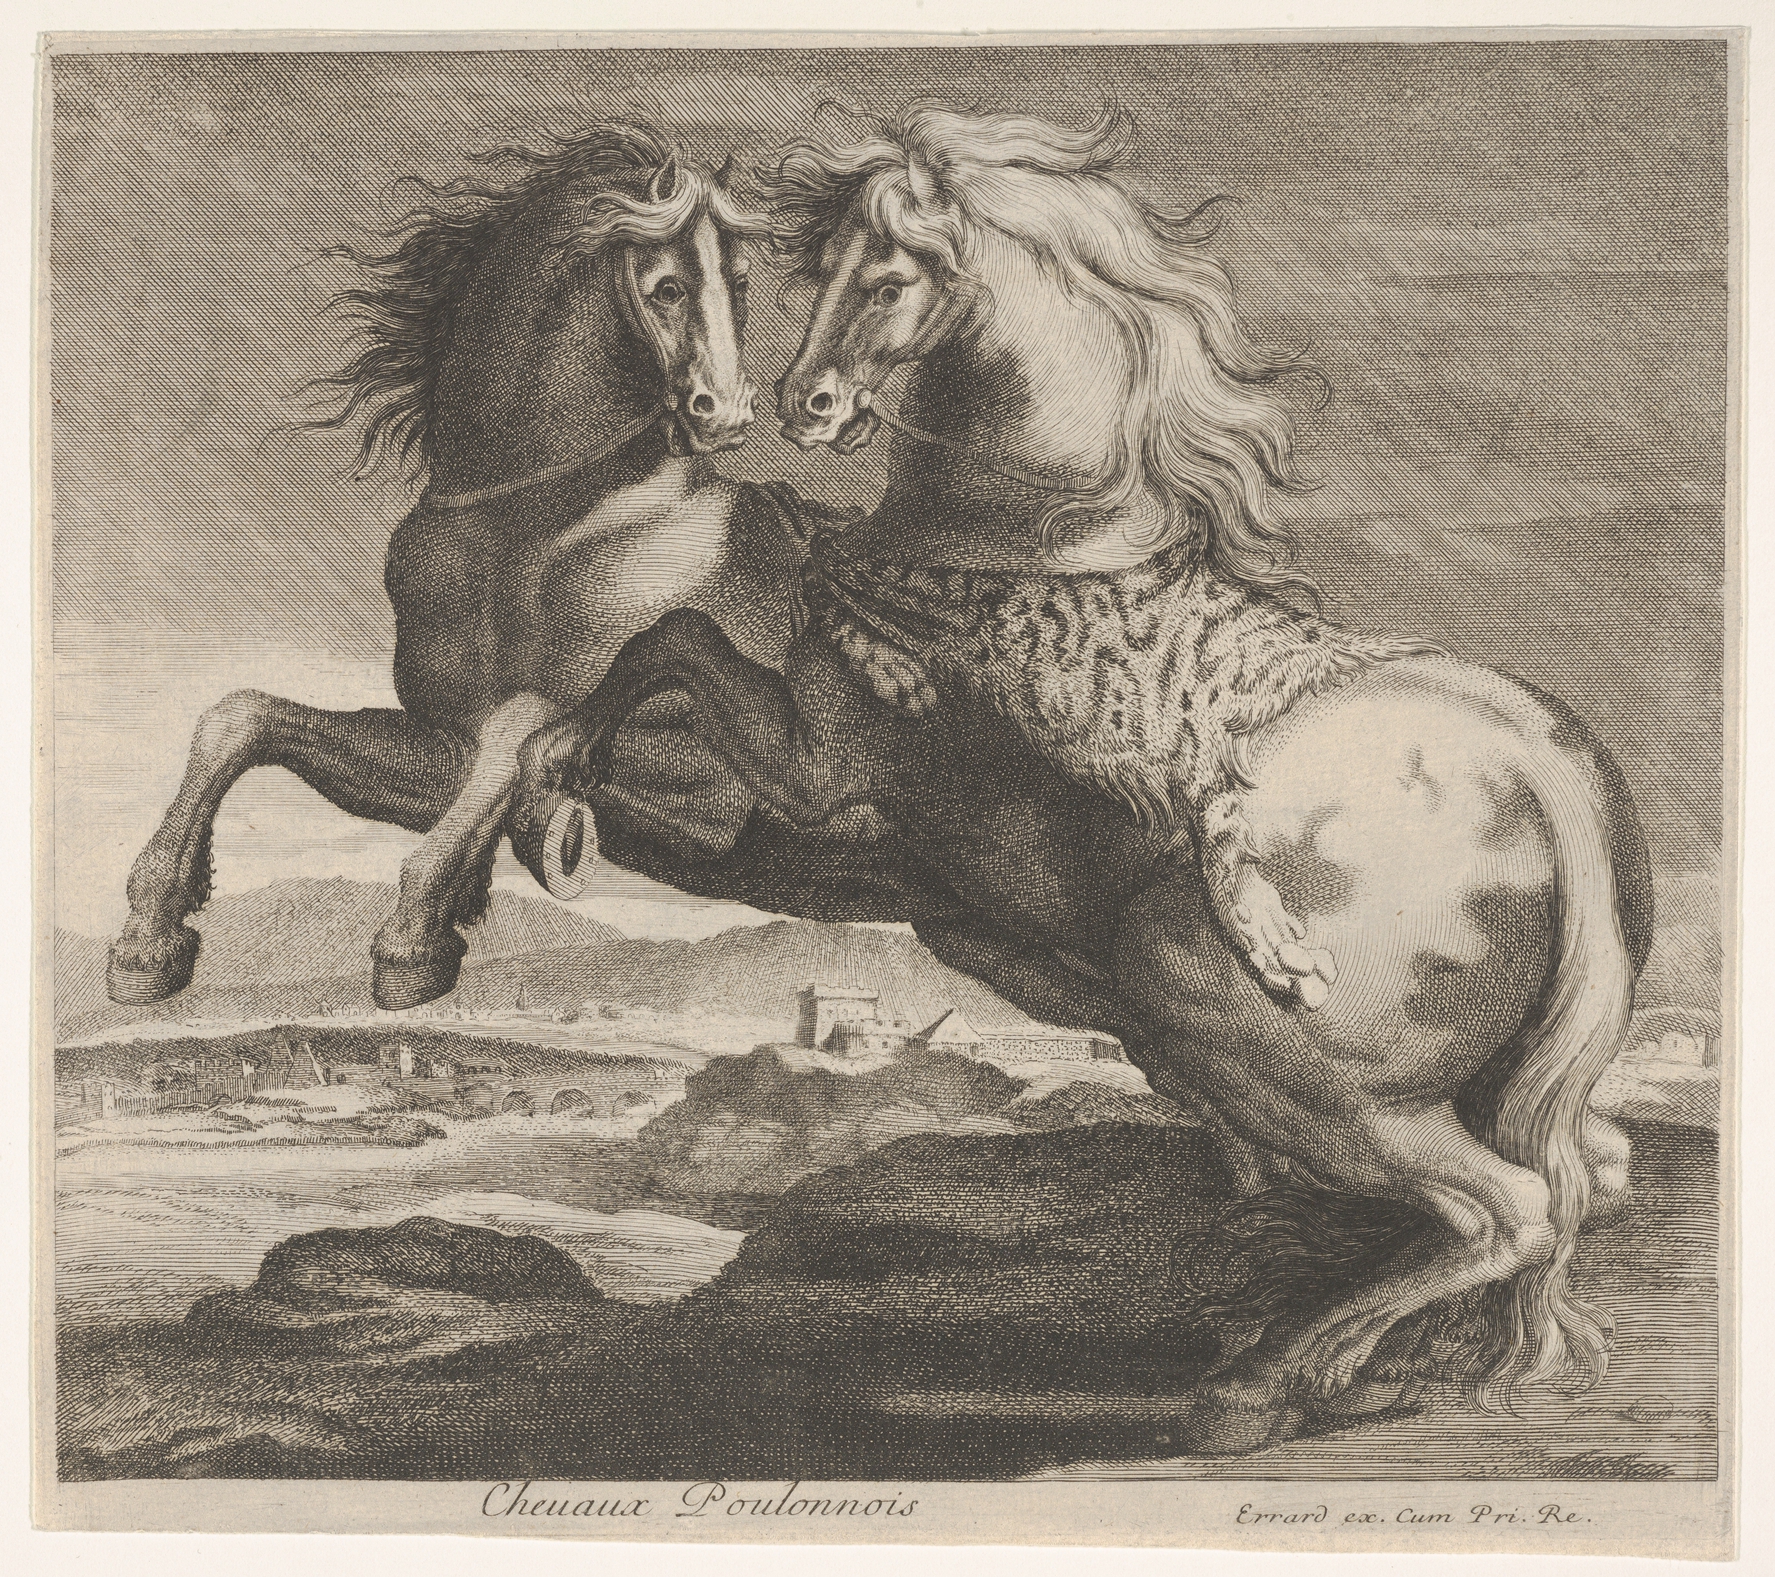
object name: print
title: Chevaux Poulonnois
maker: charles errard le fils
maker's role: artist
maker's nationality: french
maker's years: 1606-1689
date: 1606-1689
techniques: engraving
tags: horses